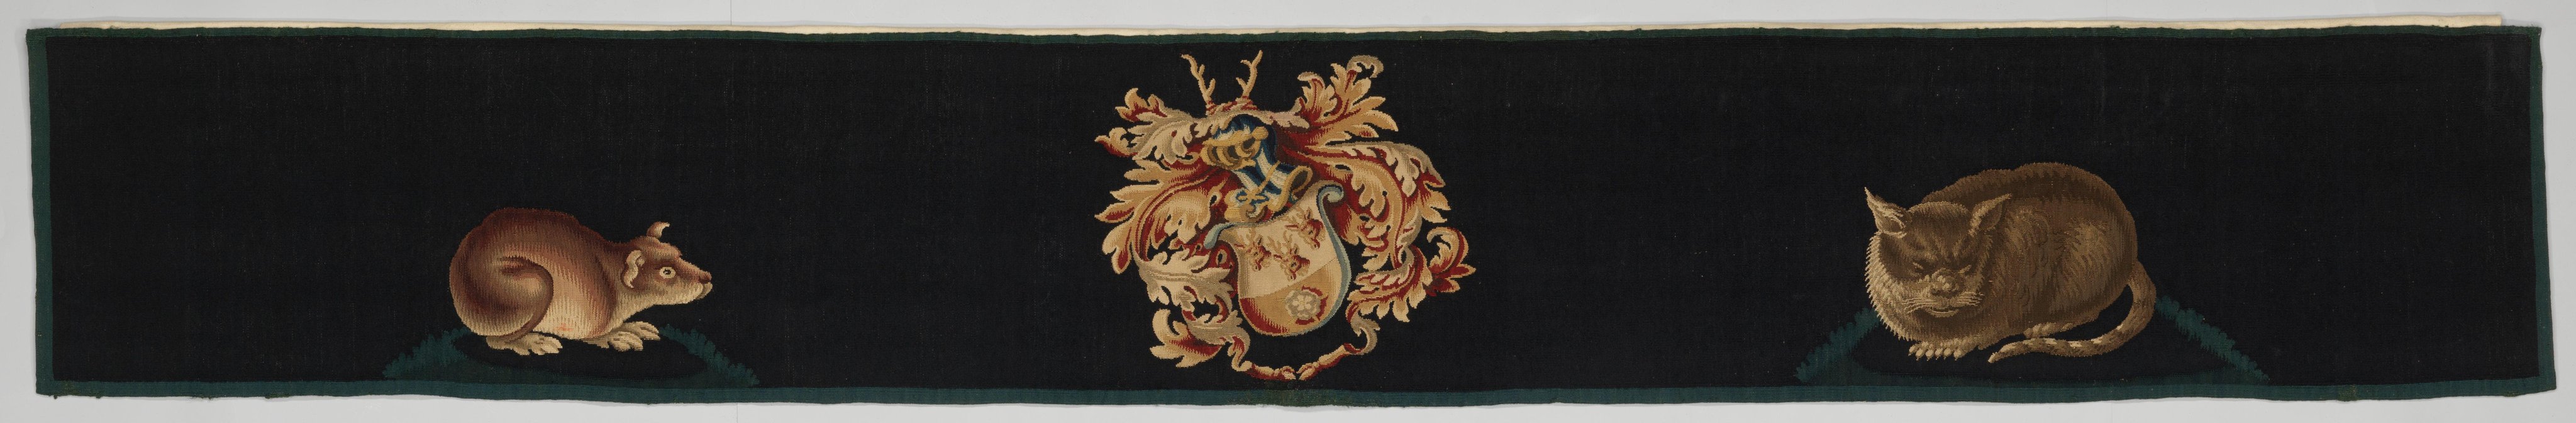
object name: schoorsteenfries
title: Schoorsteenval met het familiewapen Spiegel (fragment)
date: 1624-1644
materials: linen, silk, wool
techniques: tapestry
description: Mantelpiece drape with the Spiegel arms. Tapestry. Wool and silk. Netherlands, ca. 1610 - 1640.